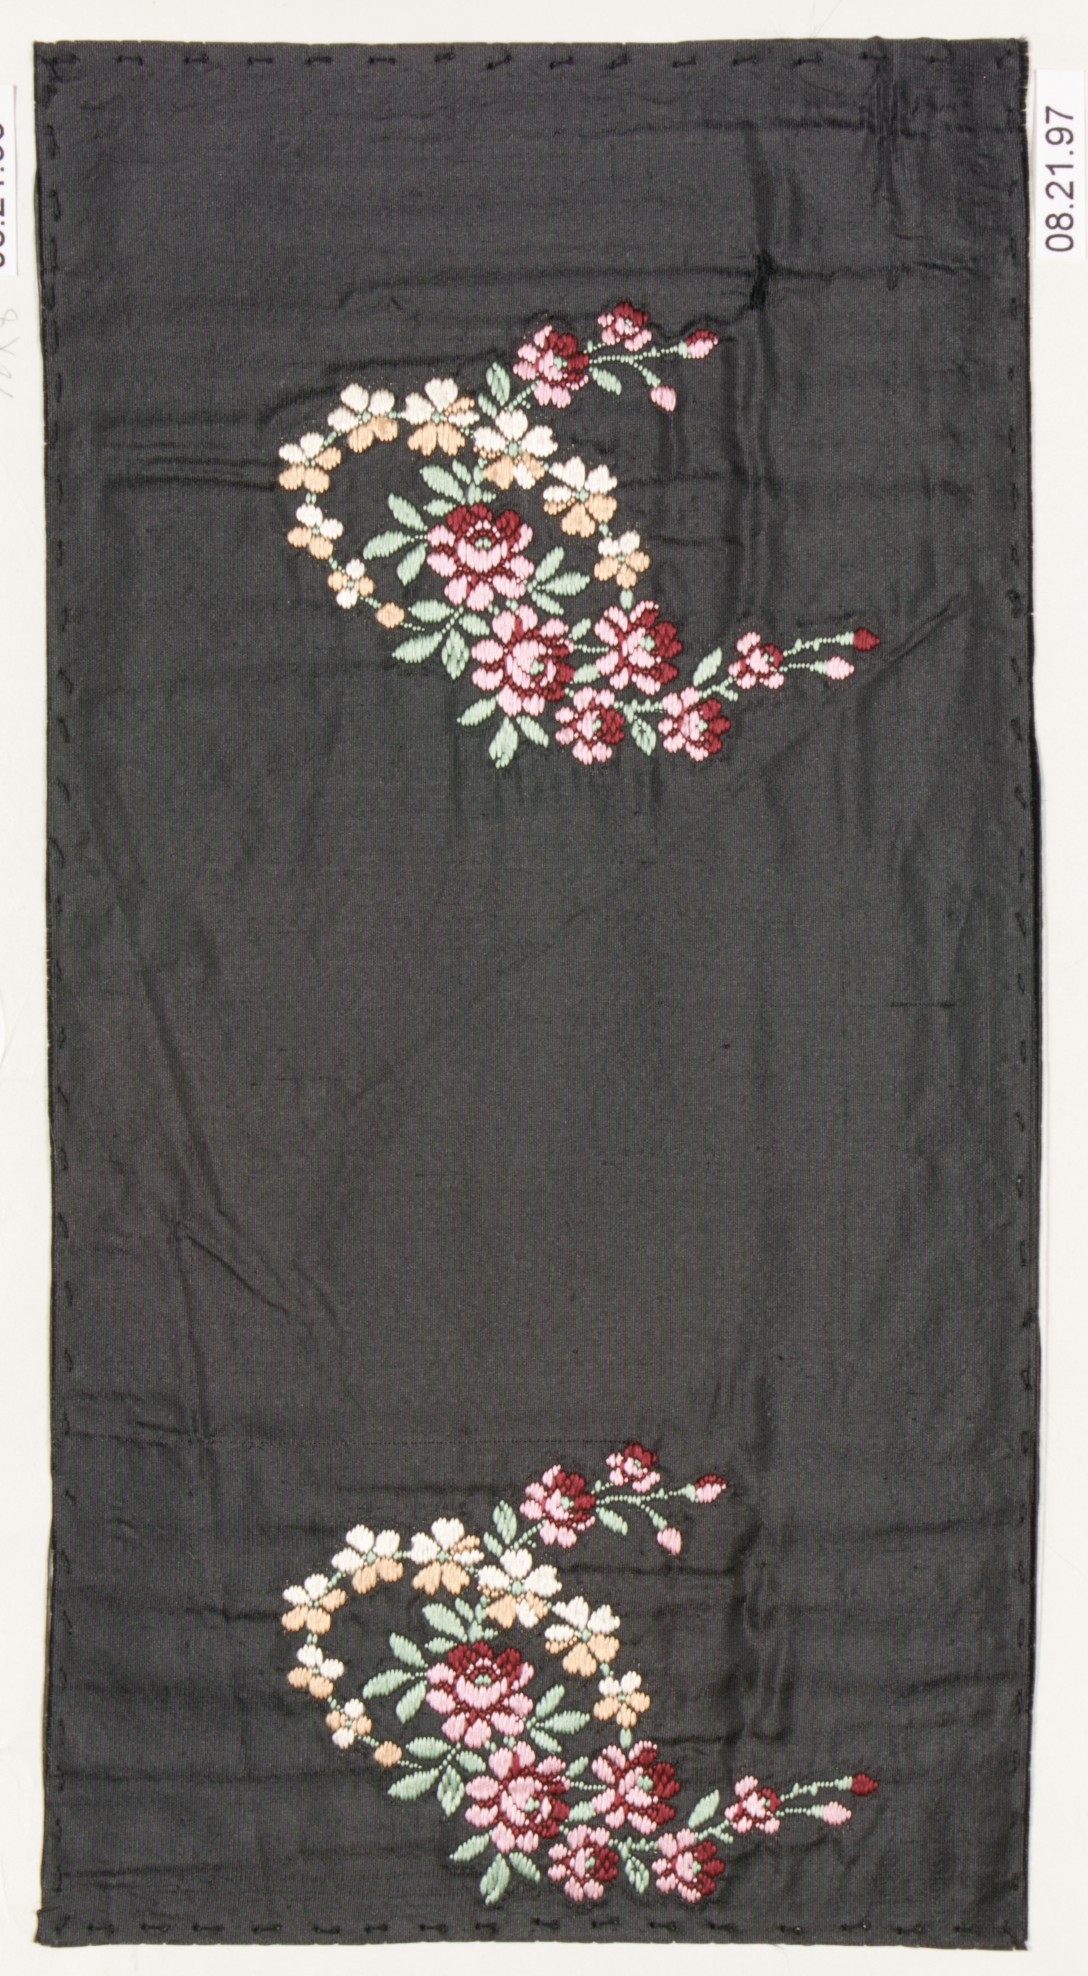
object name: textile sample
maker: Anonymous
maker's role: designer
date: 1900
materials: silk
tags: flowers